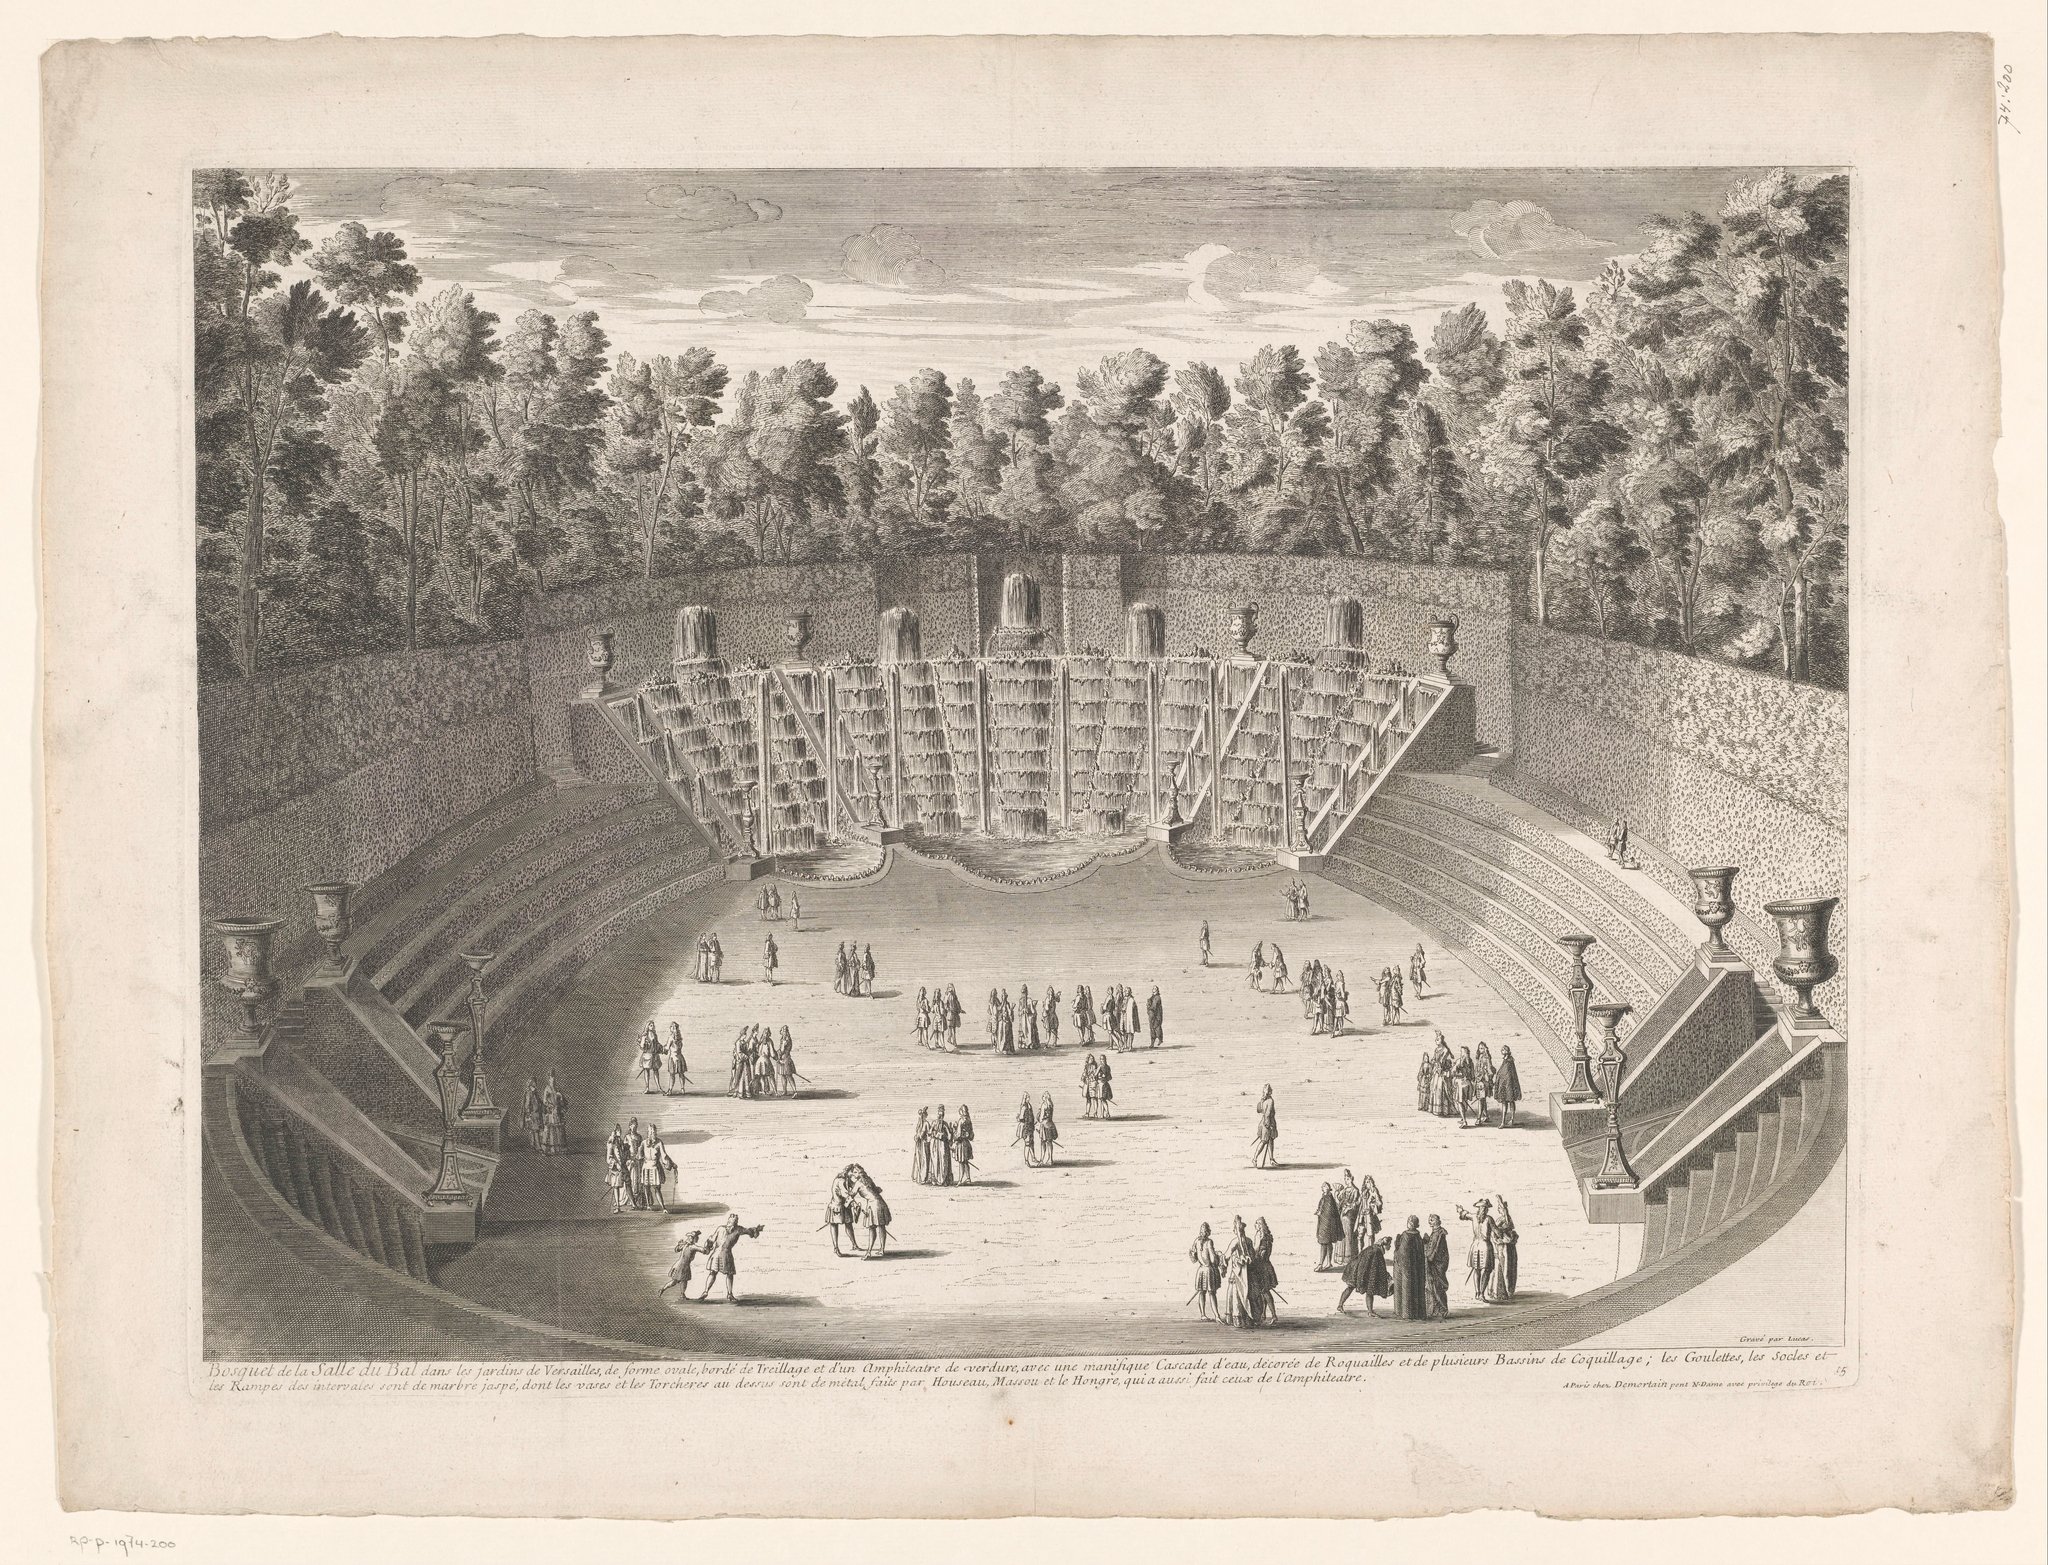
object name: print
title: Bosquet de la salle du bal dans les jardins de Versailles, de forme ovale (...)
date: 1715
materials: paper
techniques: engraving, etching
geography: paris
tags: amphitheatre, garden fountain, french or architectonic garden; formal garden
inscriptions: collector's mark: Lugt 2760, collector's mark: Lugt 2228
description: Prent ook gebruikt in: Les Plans, Profils, Et Elevations, Des Ville, Et Château De Versailles (...). Parijs: Gilles de Demortain, [1715].